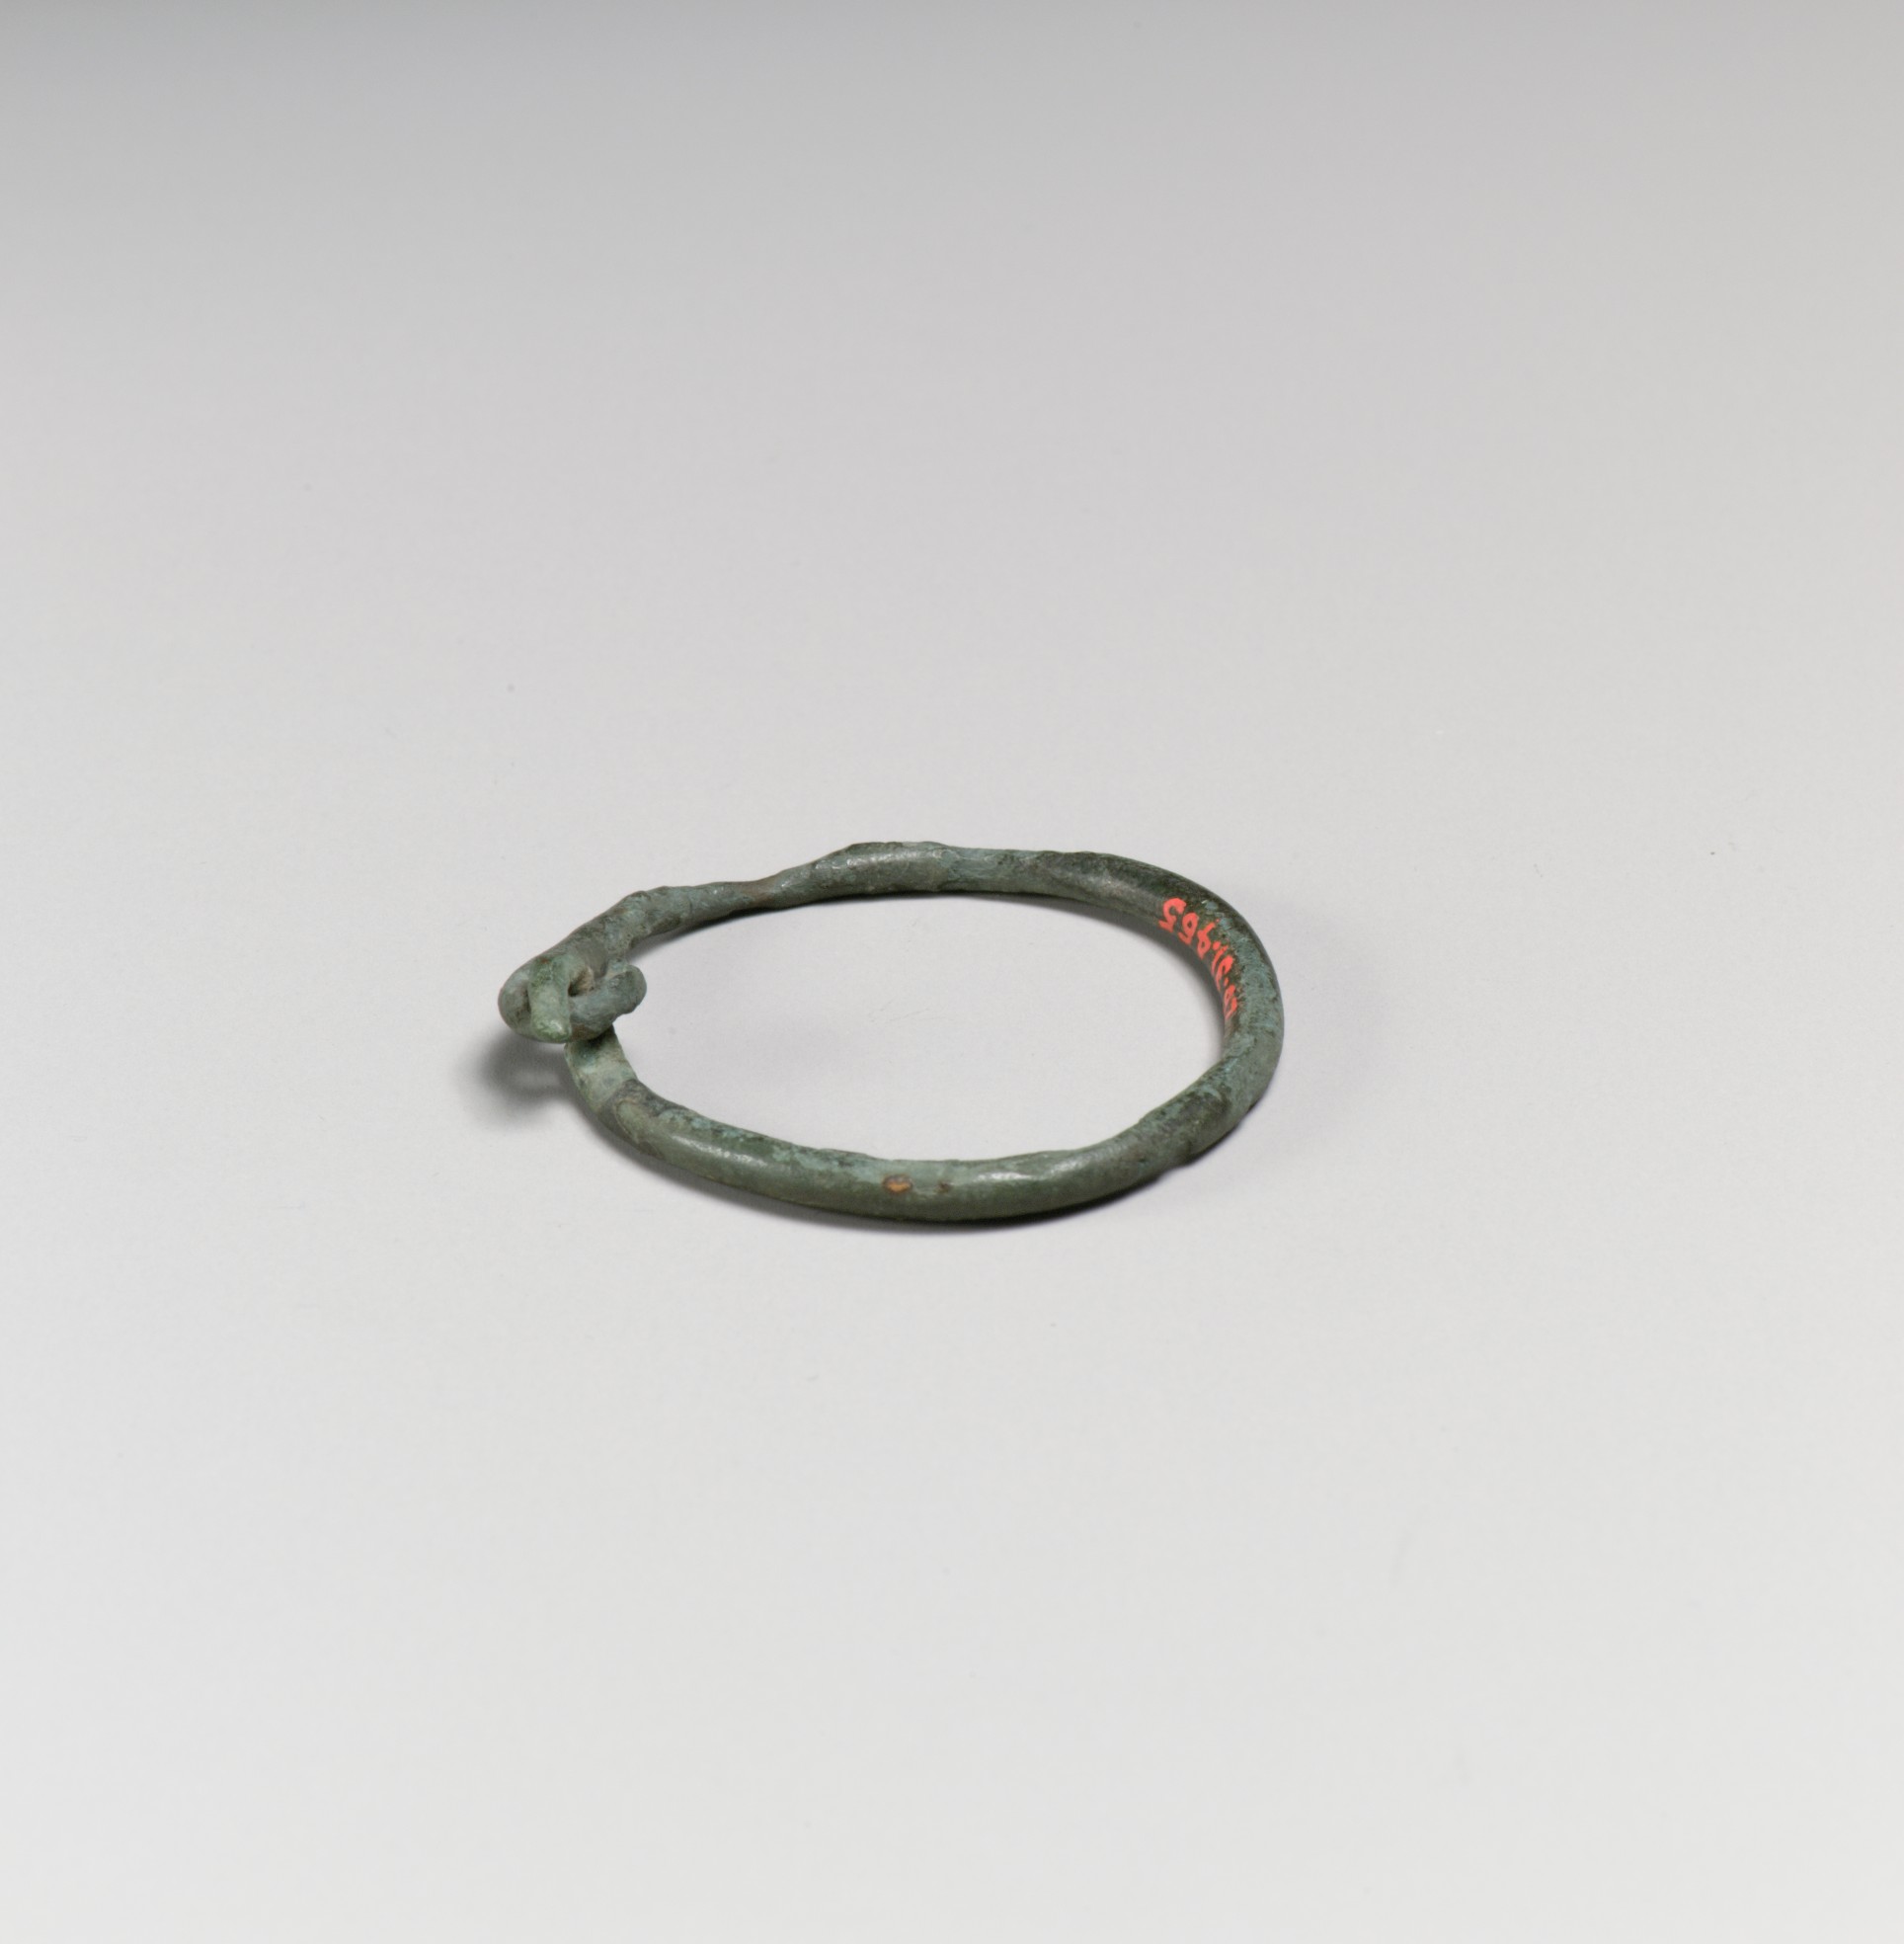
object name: bracelet, child's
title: Small bronze annular bangle with clasp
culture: minoan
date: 2000-1001 BCE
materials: bronze